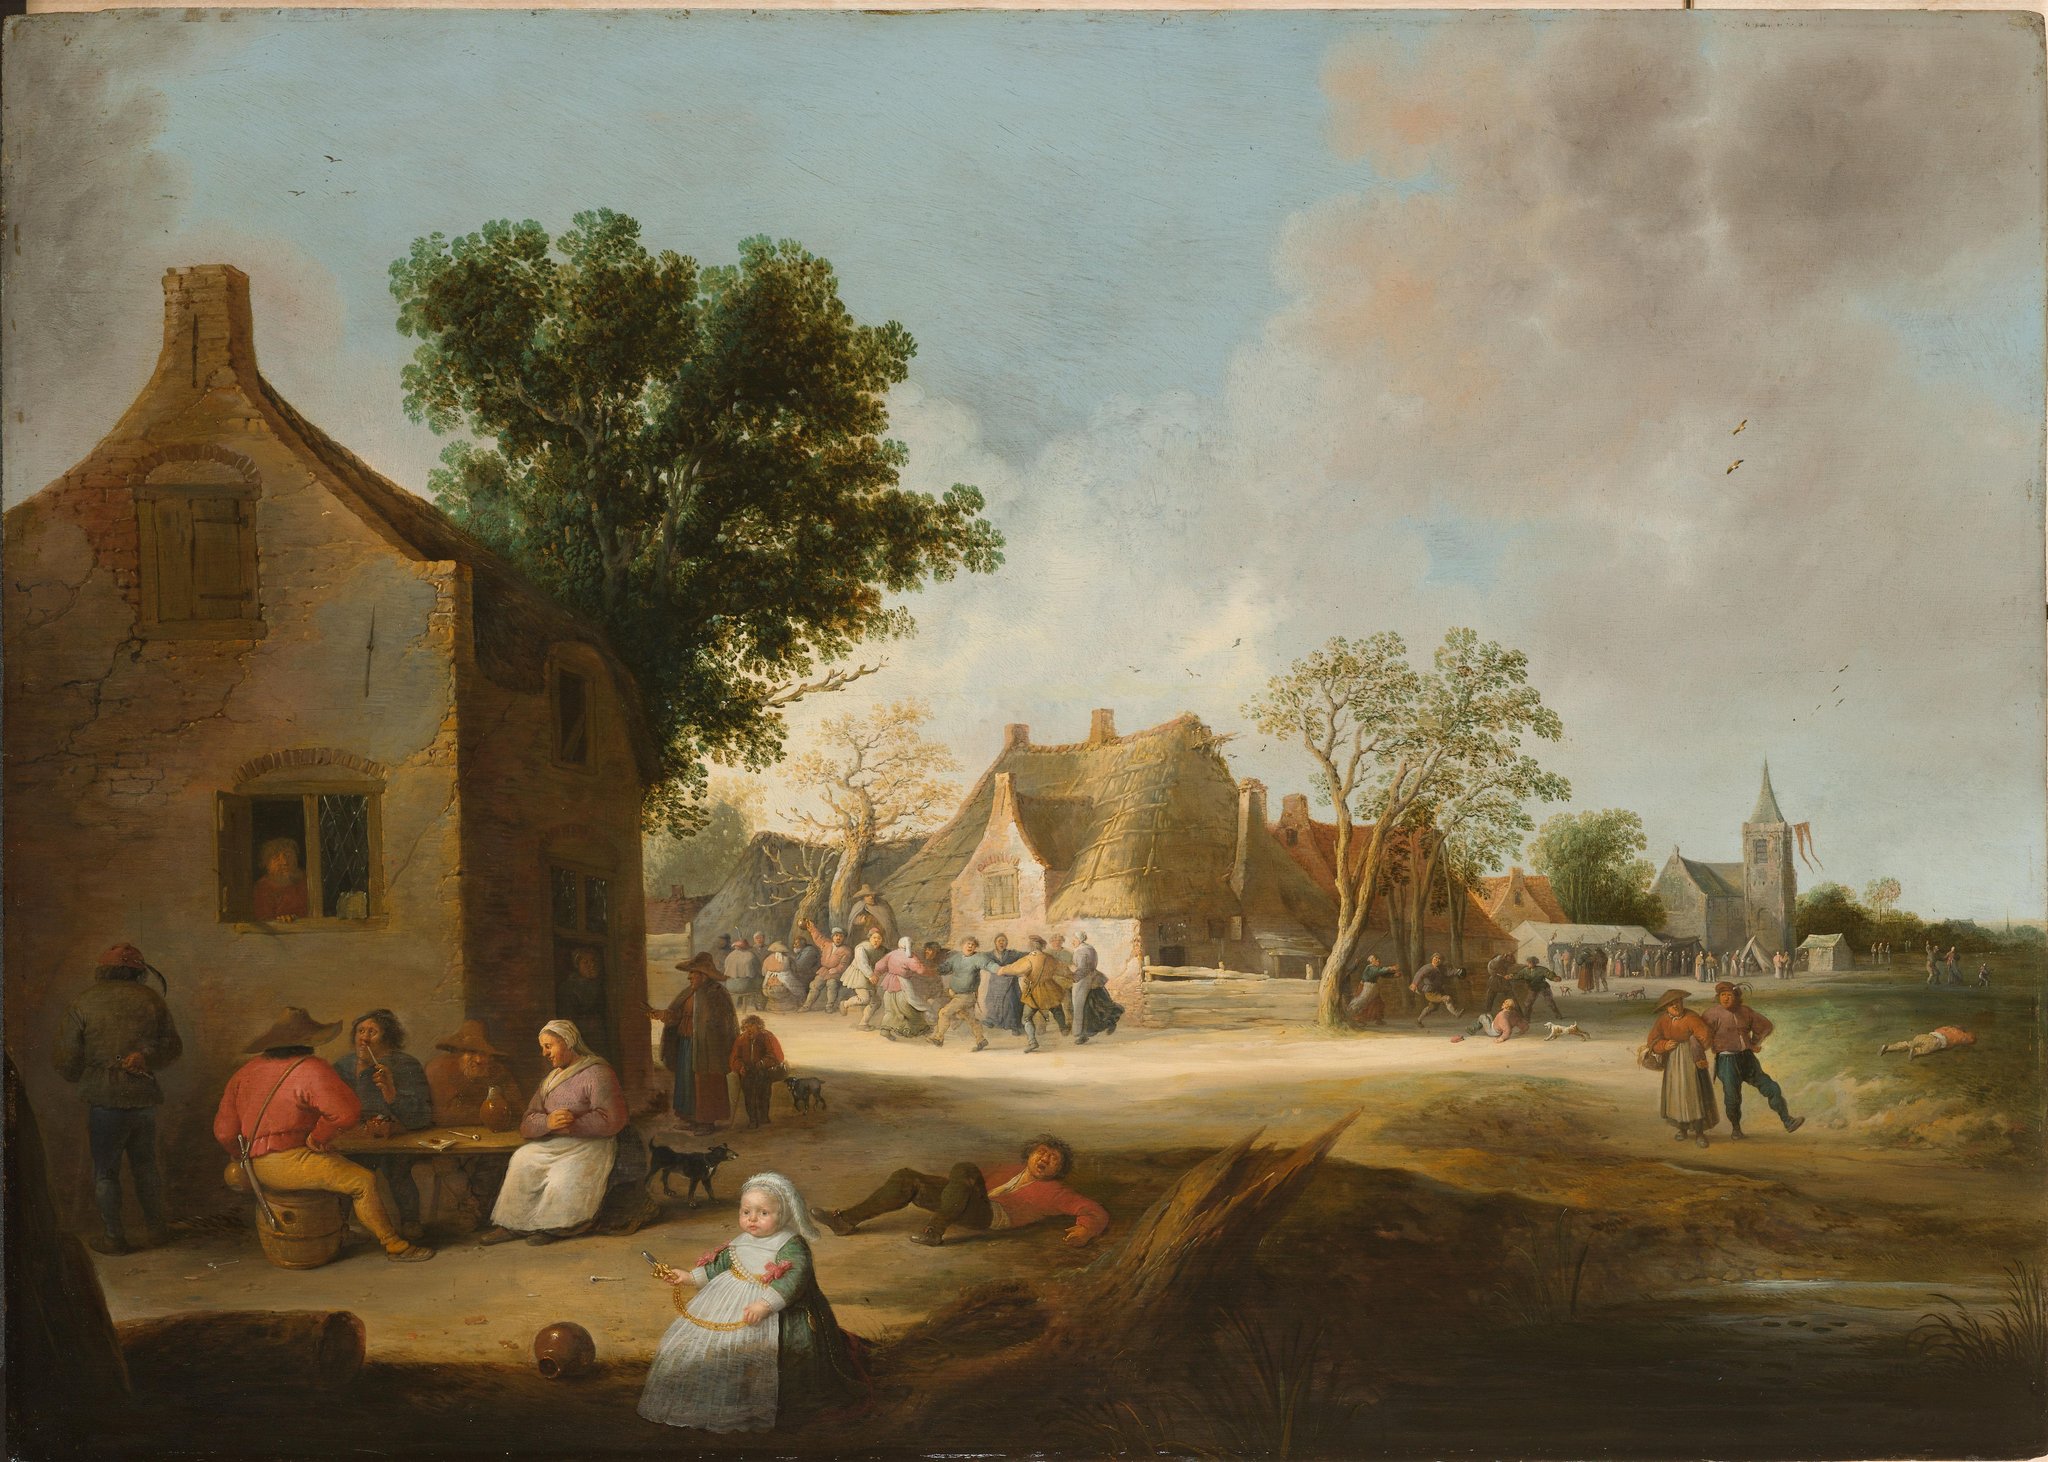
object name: painting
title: Country Kermis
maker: pieter de bloot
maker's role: draughtsman, painter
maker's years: 1601-1658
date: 1639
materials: oil, panel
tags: village, pleasure fair and circus, group dancing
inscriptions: signature and date, lower left: ‘P. De. Bloot / 1639’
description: Boerenkermis in een dorp. Links een gezelschap rond een tafel buiten een herberg. Op de voorgrond een deftig klein kind met een bijtstaaf of rammelaar. Linksachter dansen dorpelingen in een kring, daarnaast wordt gevochten. In de verte kraampjes voor een kerk.